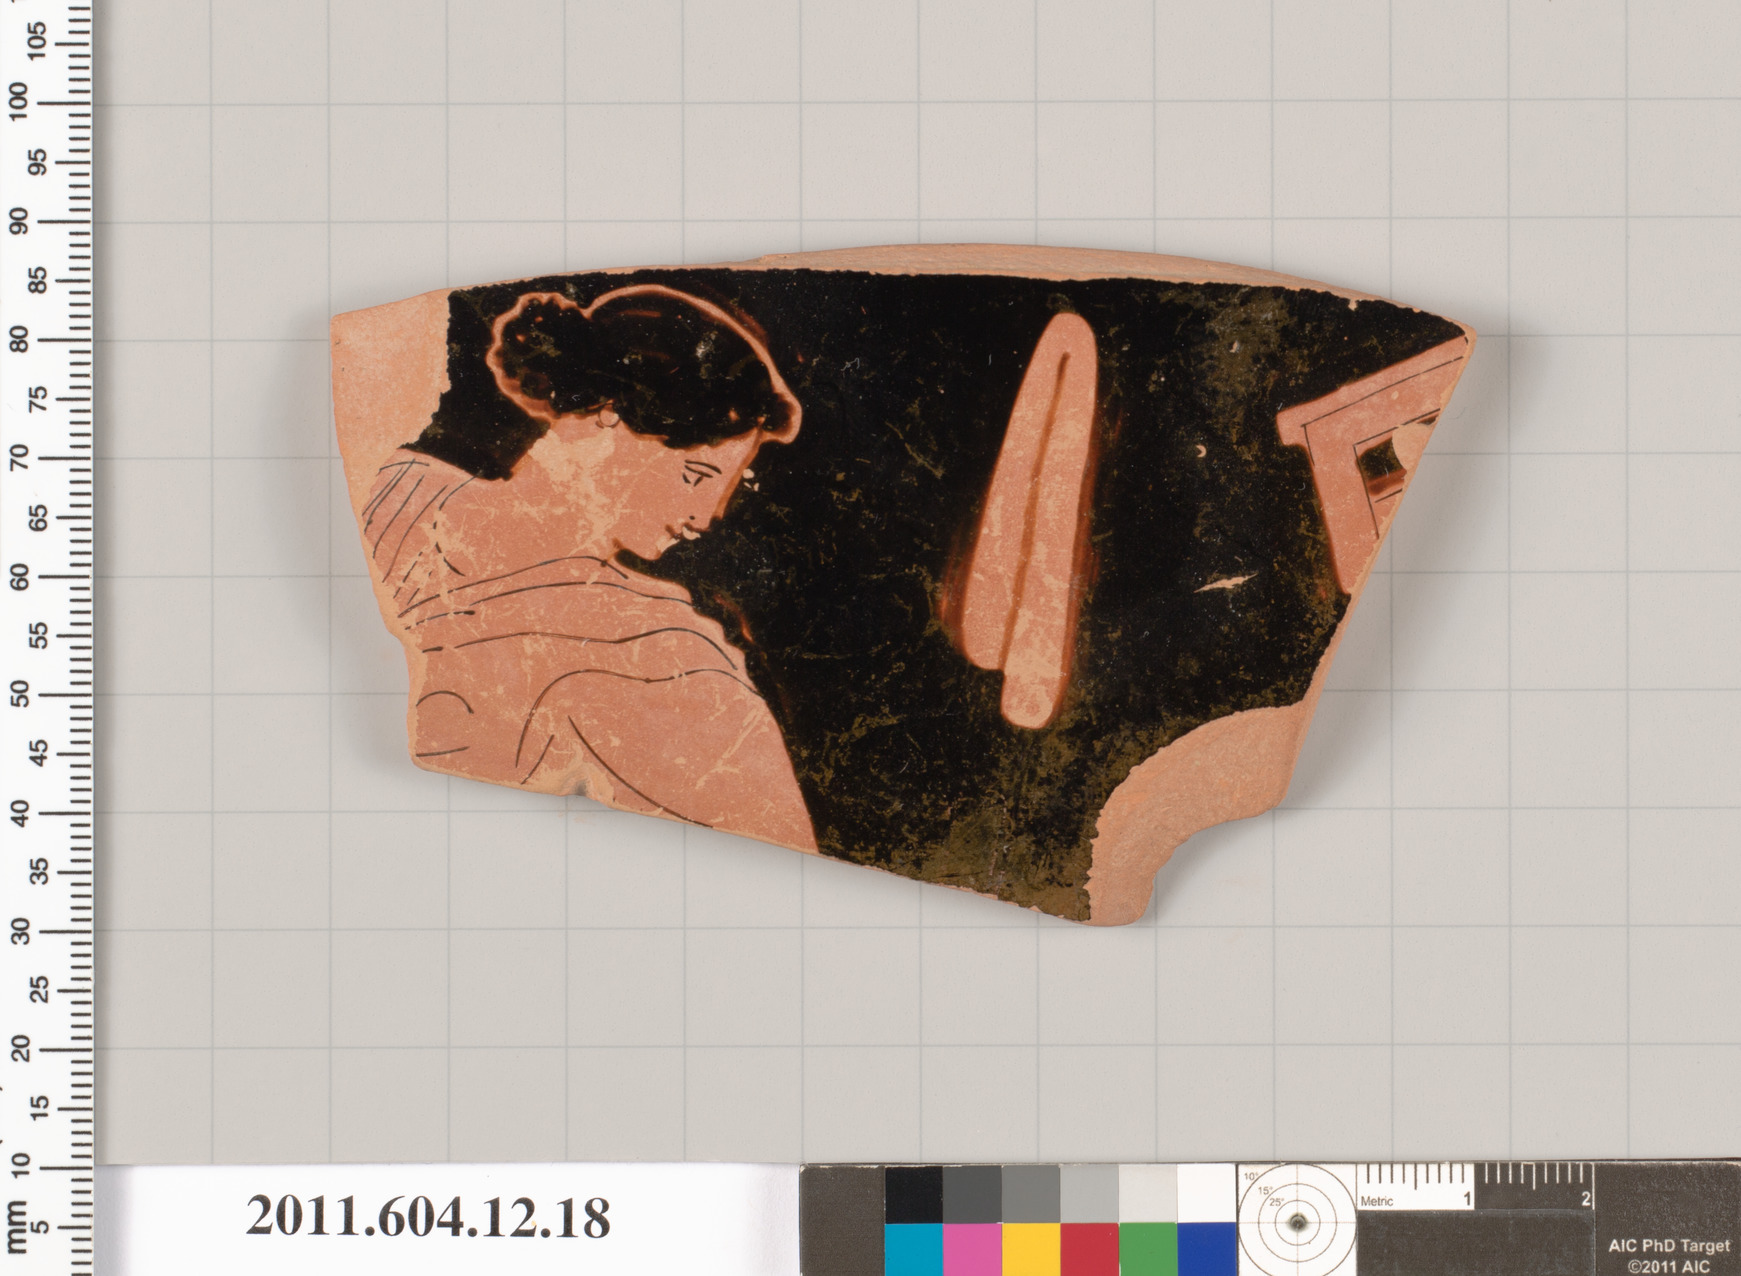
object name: undetermined closed shape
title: Terracotta fragment of a closed shape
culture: greek, south italian, apulian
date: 367-335 BCE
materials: terracotta